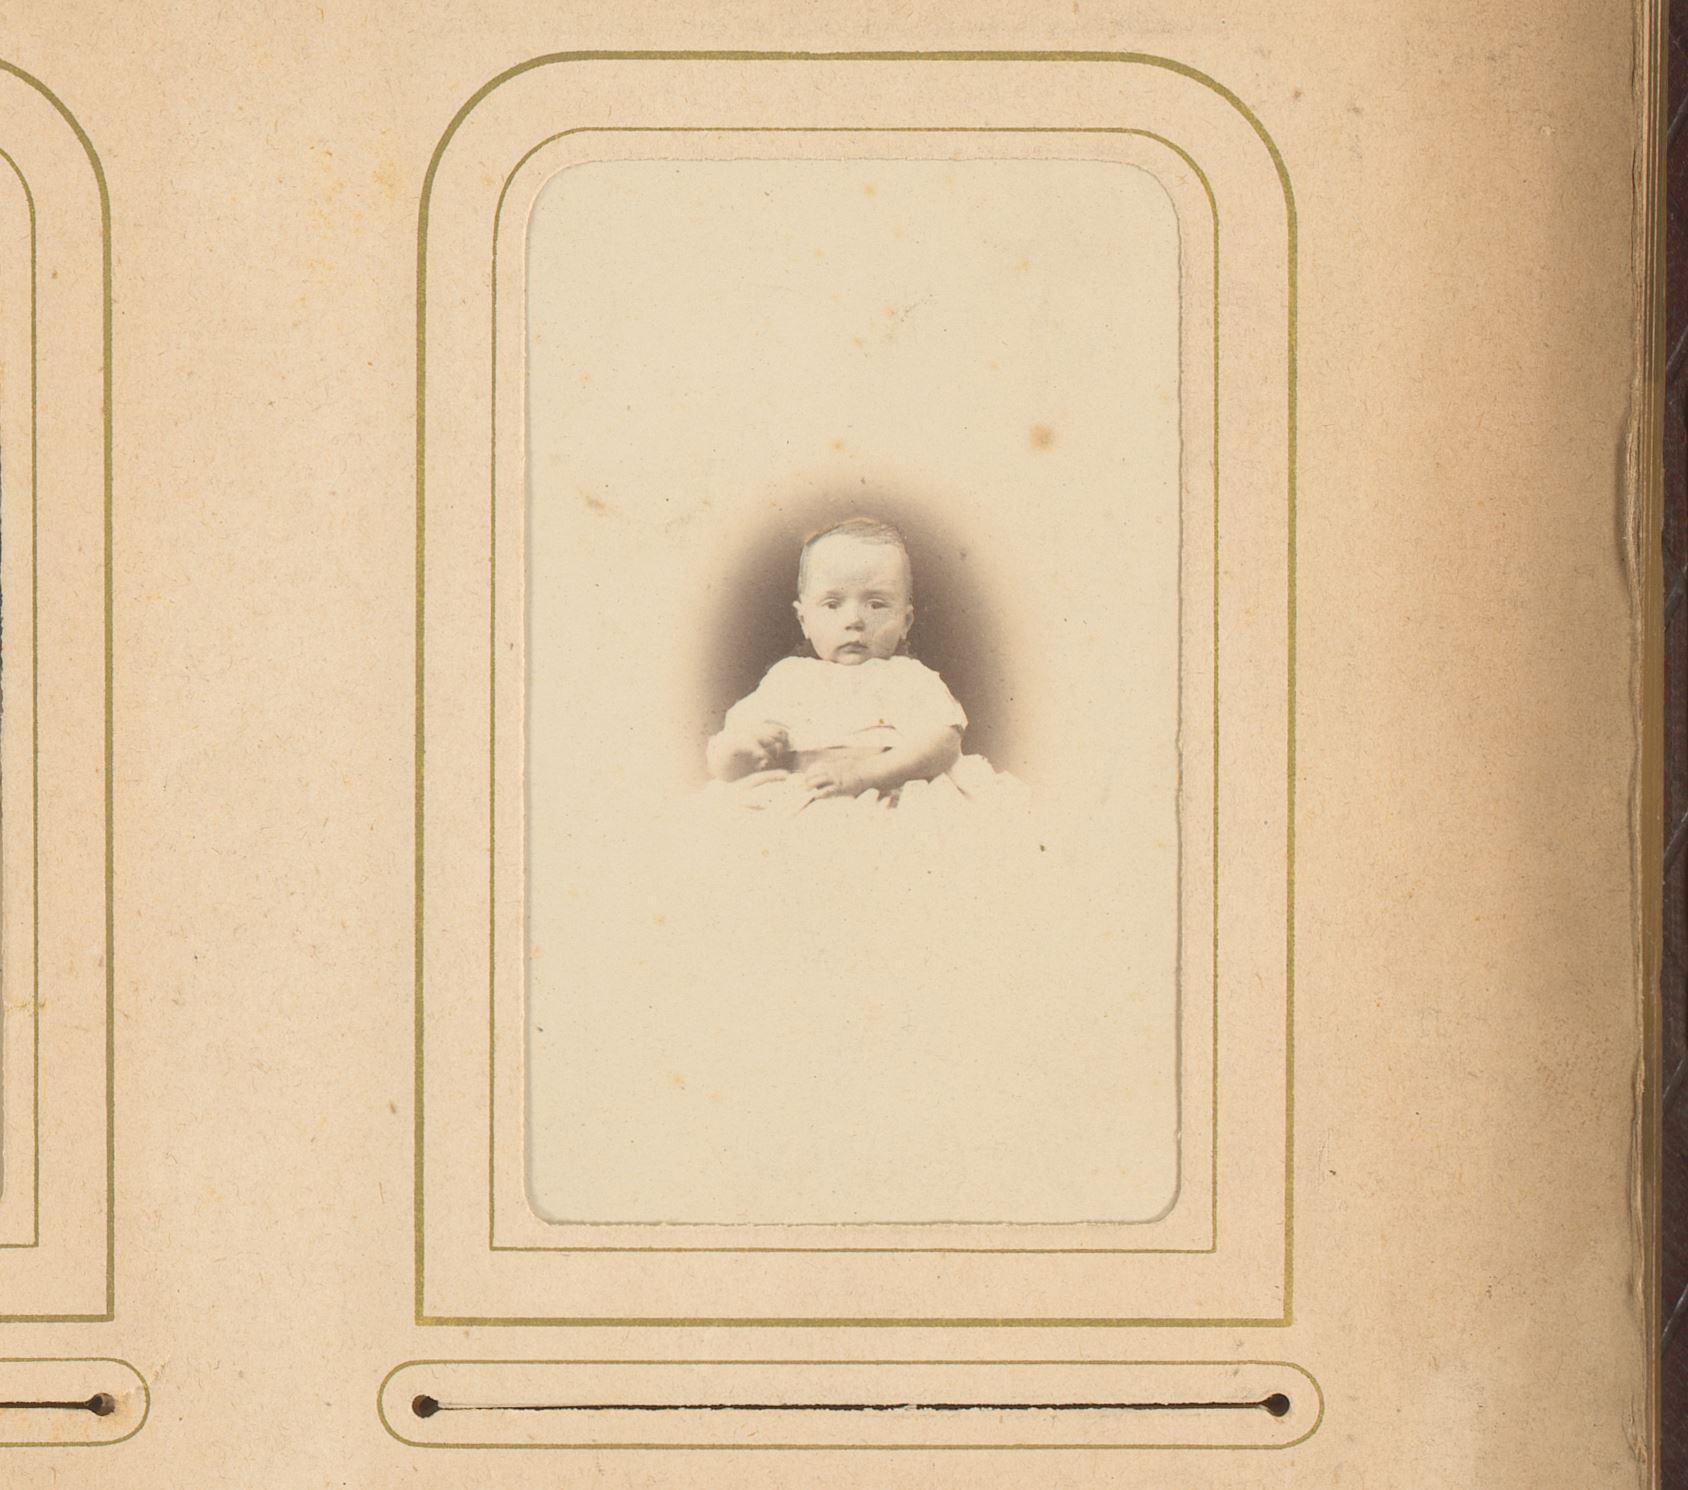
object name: album leaf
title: Portret van een baby in doopjurk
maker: a. böeseken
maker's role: fotograaf, lithograaf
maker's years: 1834-1919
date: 1858-1890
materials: cardboard, photographic support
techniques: albumen print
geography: rotterdam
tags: baptism, christening gown, historical persons, infant, baby ~ the ages of man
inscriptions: inscription: ‘Photographisch Atelier/ A. Böeseken/ Hoogstraat over de Vlasmarkt/ ROTTERDAM.’